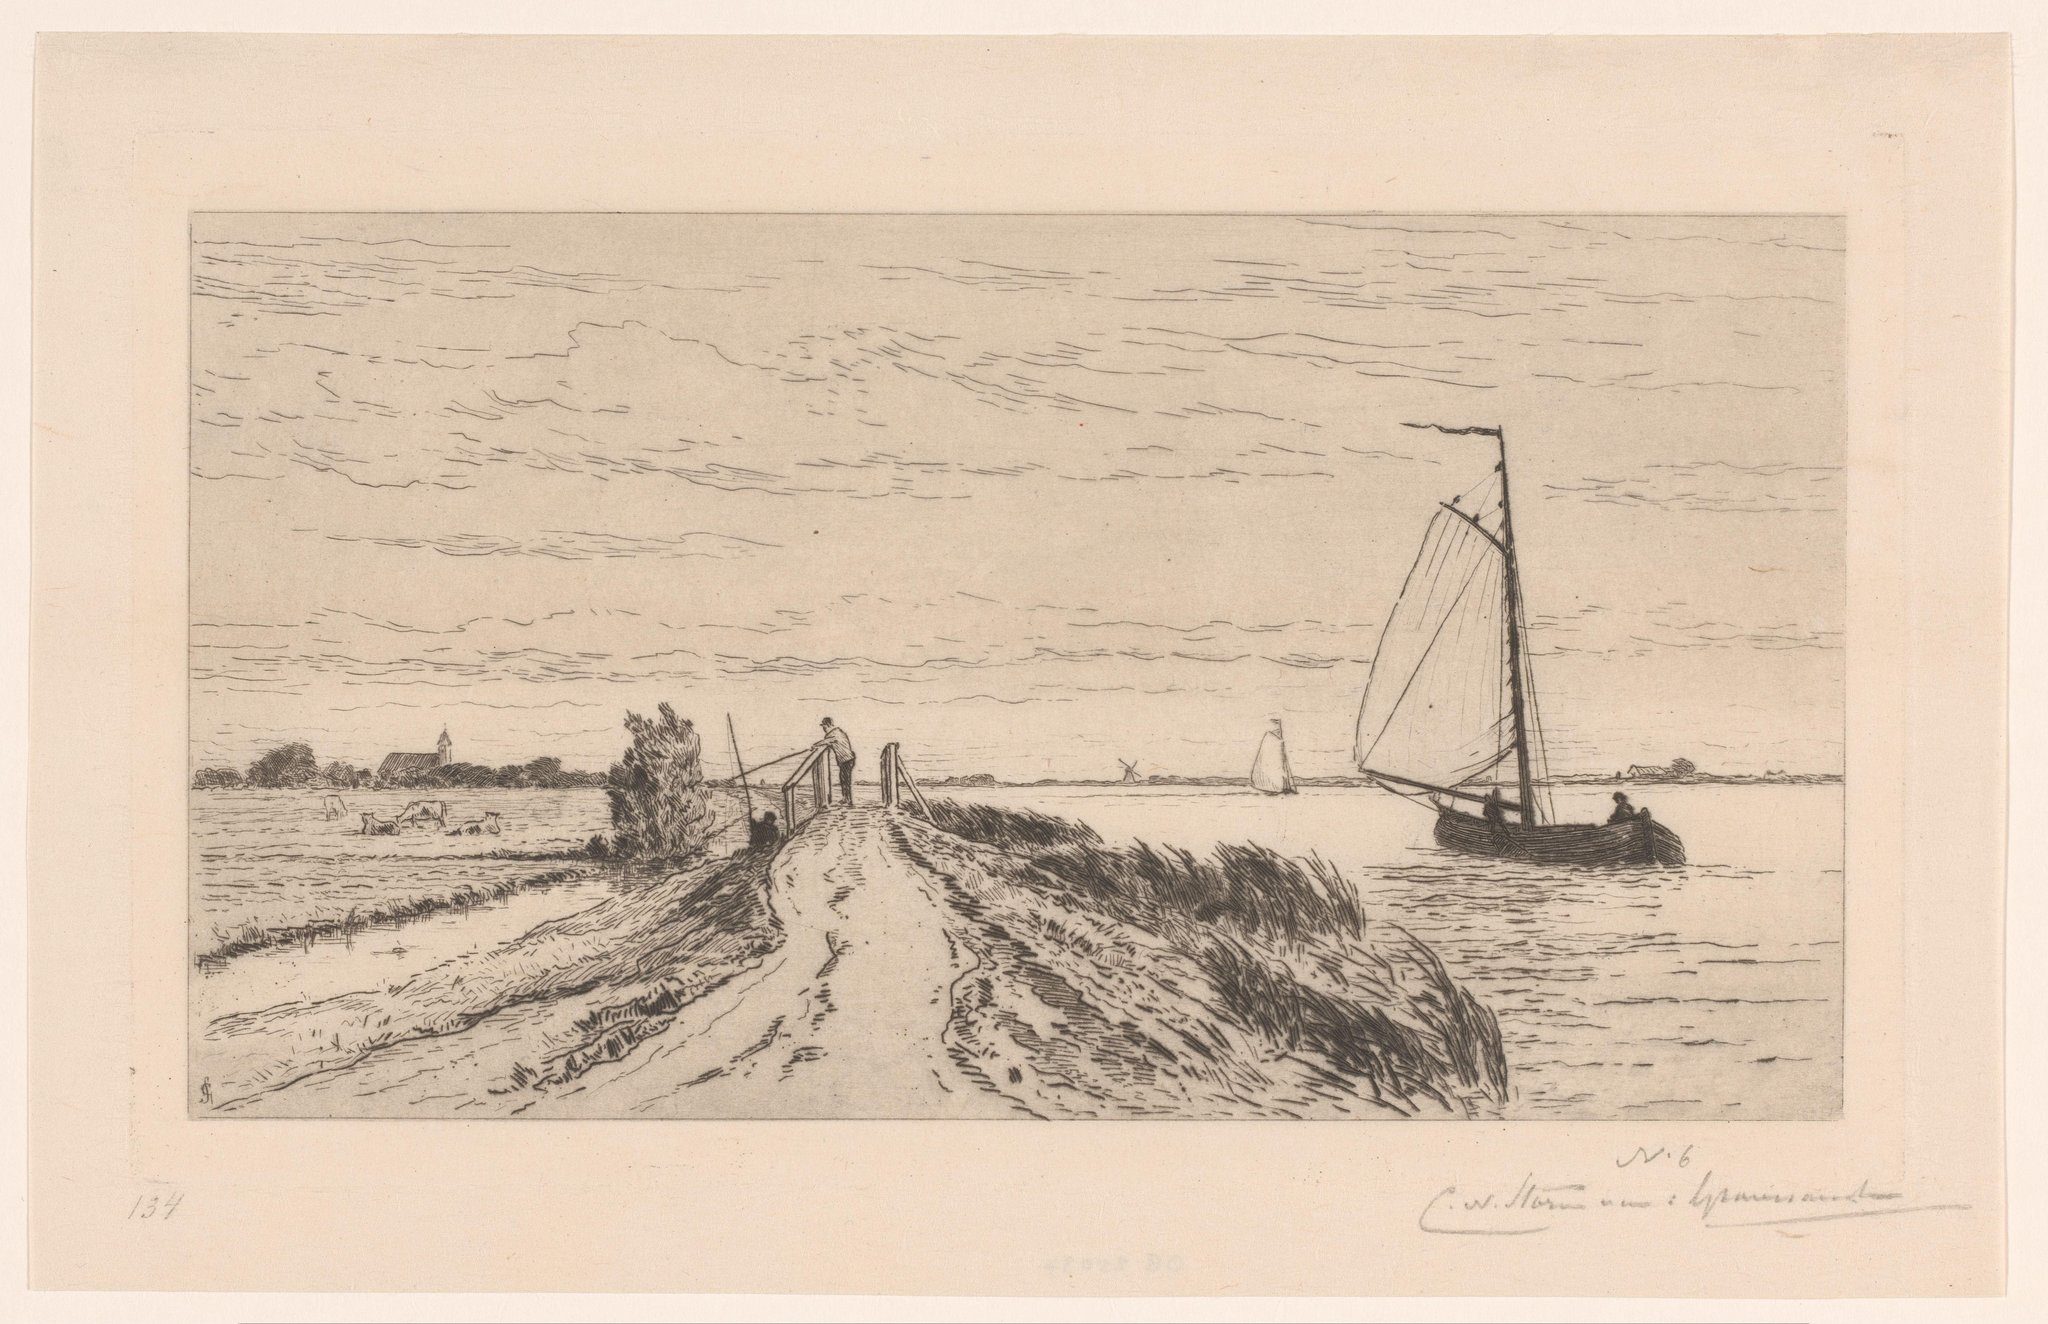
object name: print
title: Sketches of Holland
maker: carel nicolaas storm van s-gravesande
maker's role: draughtsman, print maker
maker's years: 1841-1924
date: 1851-1924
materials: paper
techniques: drypoint, etching, intaglio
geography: netherlands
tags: sailing-ship, sailing-boat, river (+ landscape with figures, staffage), angling, haarlem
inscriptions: number: ‘N. 6’, collector's mark: Lugt 2228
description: Rivierlandschap met zeilboten. In het midden een brug waar twee mannen vissen met hengels.